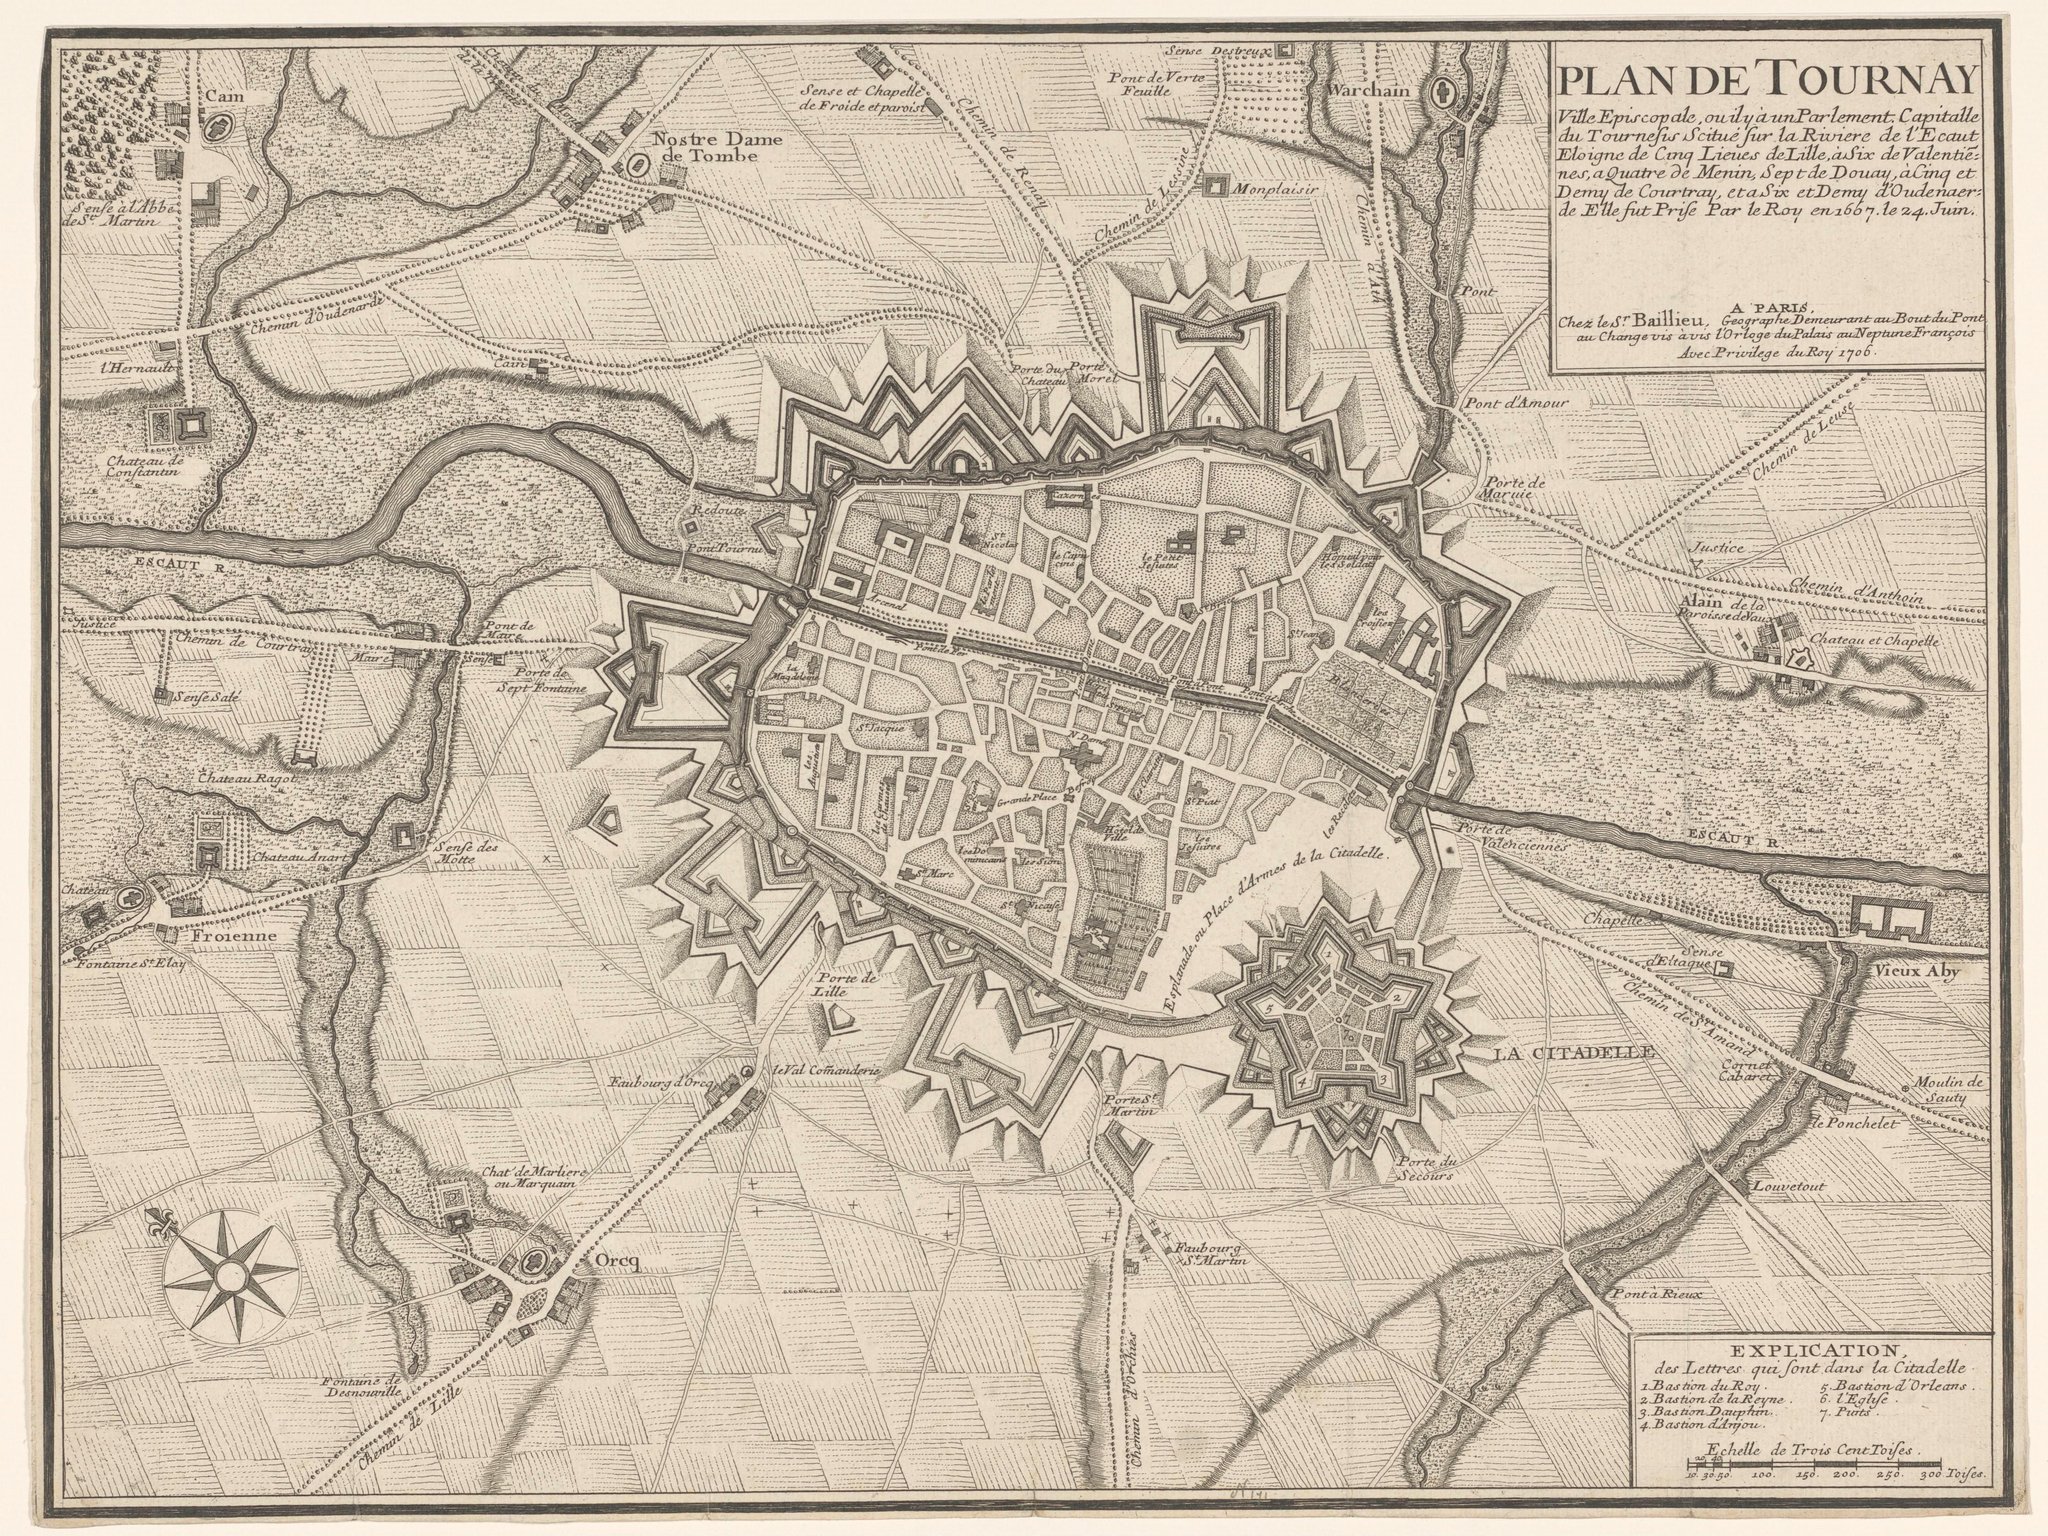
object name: area plan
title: Plan de Tournay ville episcopale, ou il y a un parlement captitalle (...)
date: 1706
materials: paper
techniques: engraving, etching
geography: paris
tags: fortified city, maps of cities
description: Plattegrond van Doornik. Rechtsboven een kader met daarin de titel. Rechtsonder een kader met legenda 1-7, en een schaalstok: Echelle de 300 Toises.